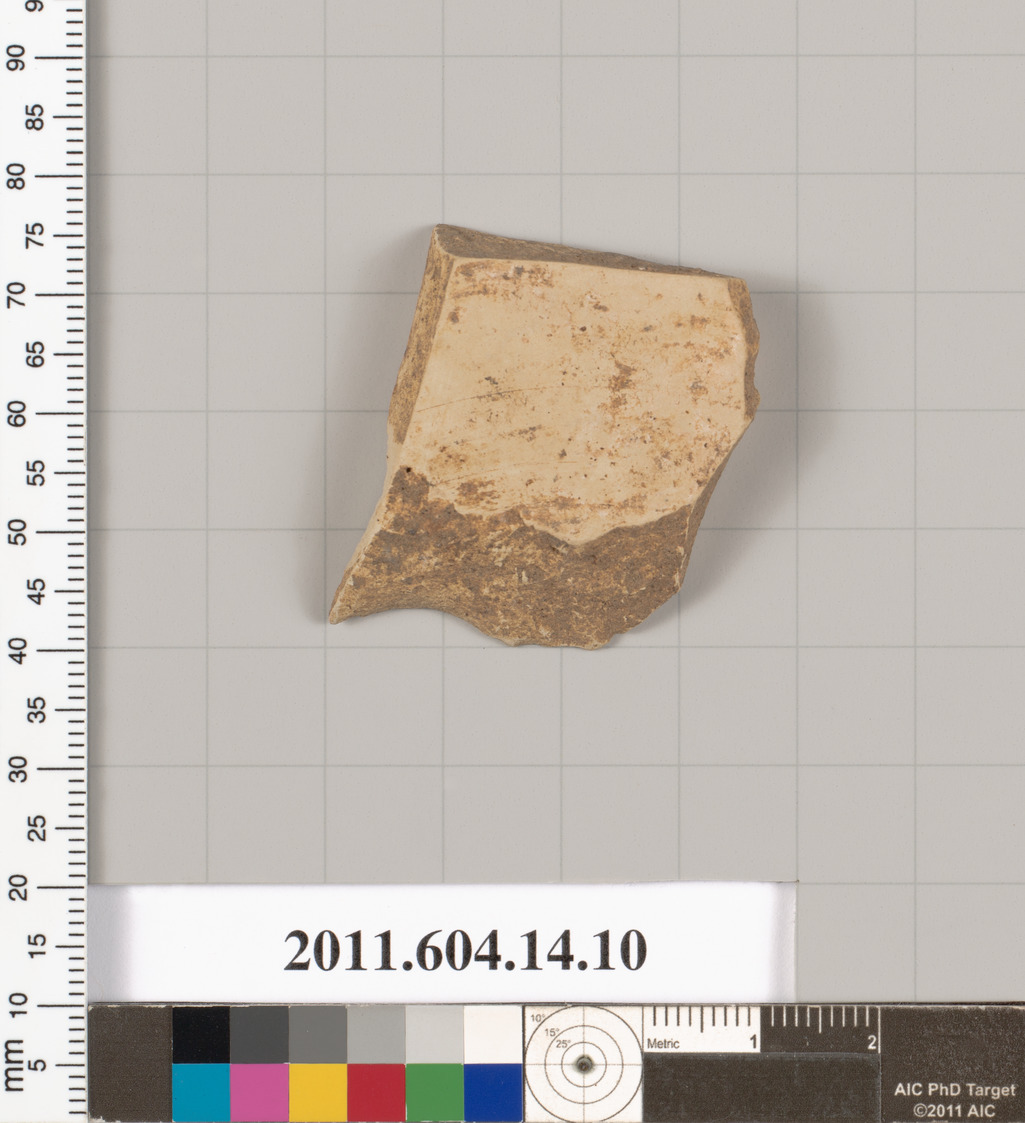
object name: undetermined shape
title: Terracotta fragment of an undetermined shape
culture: unknown fabric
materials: terracotta